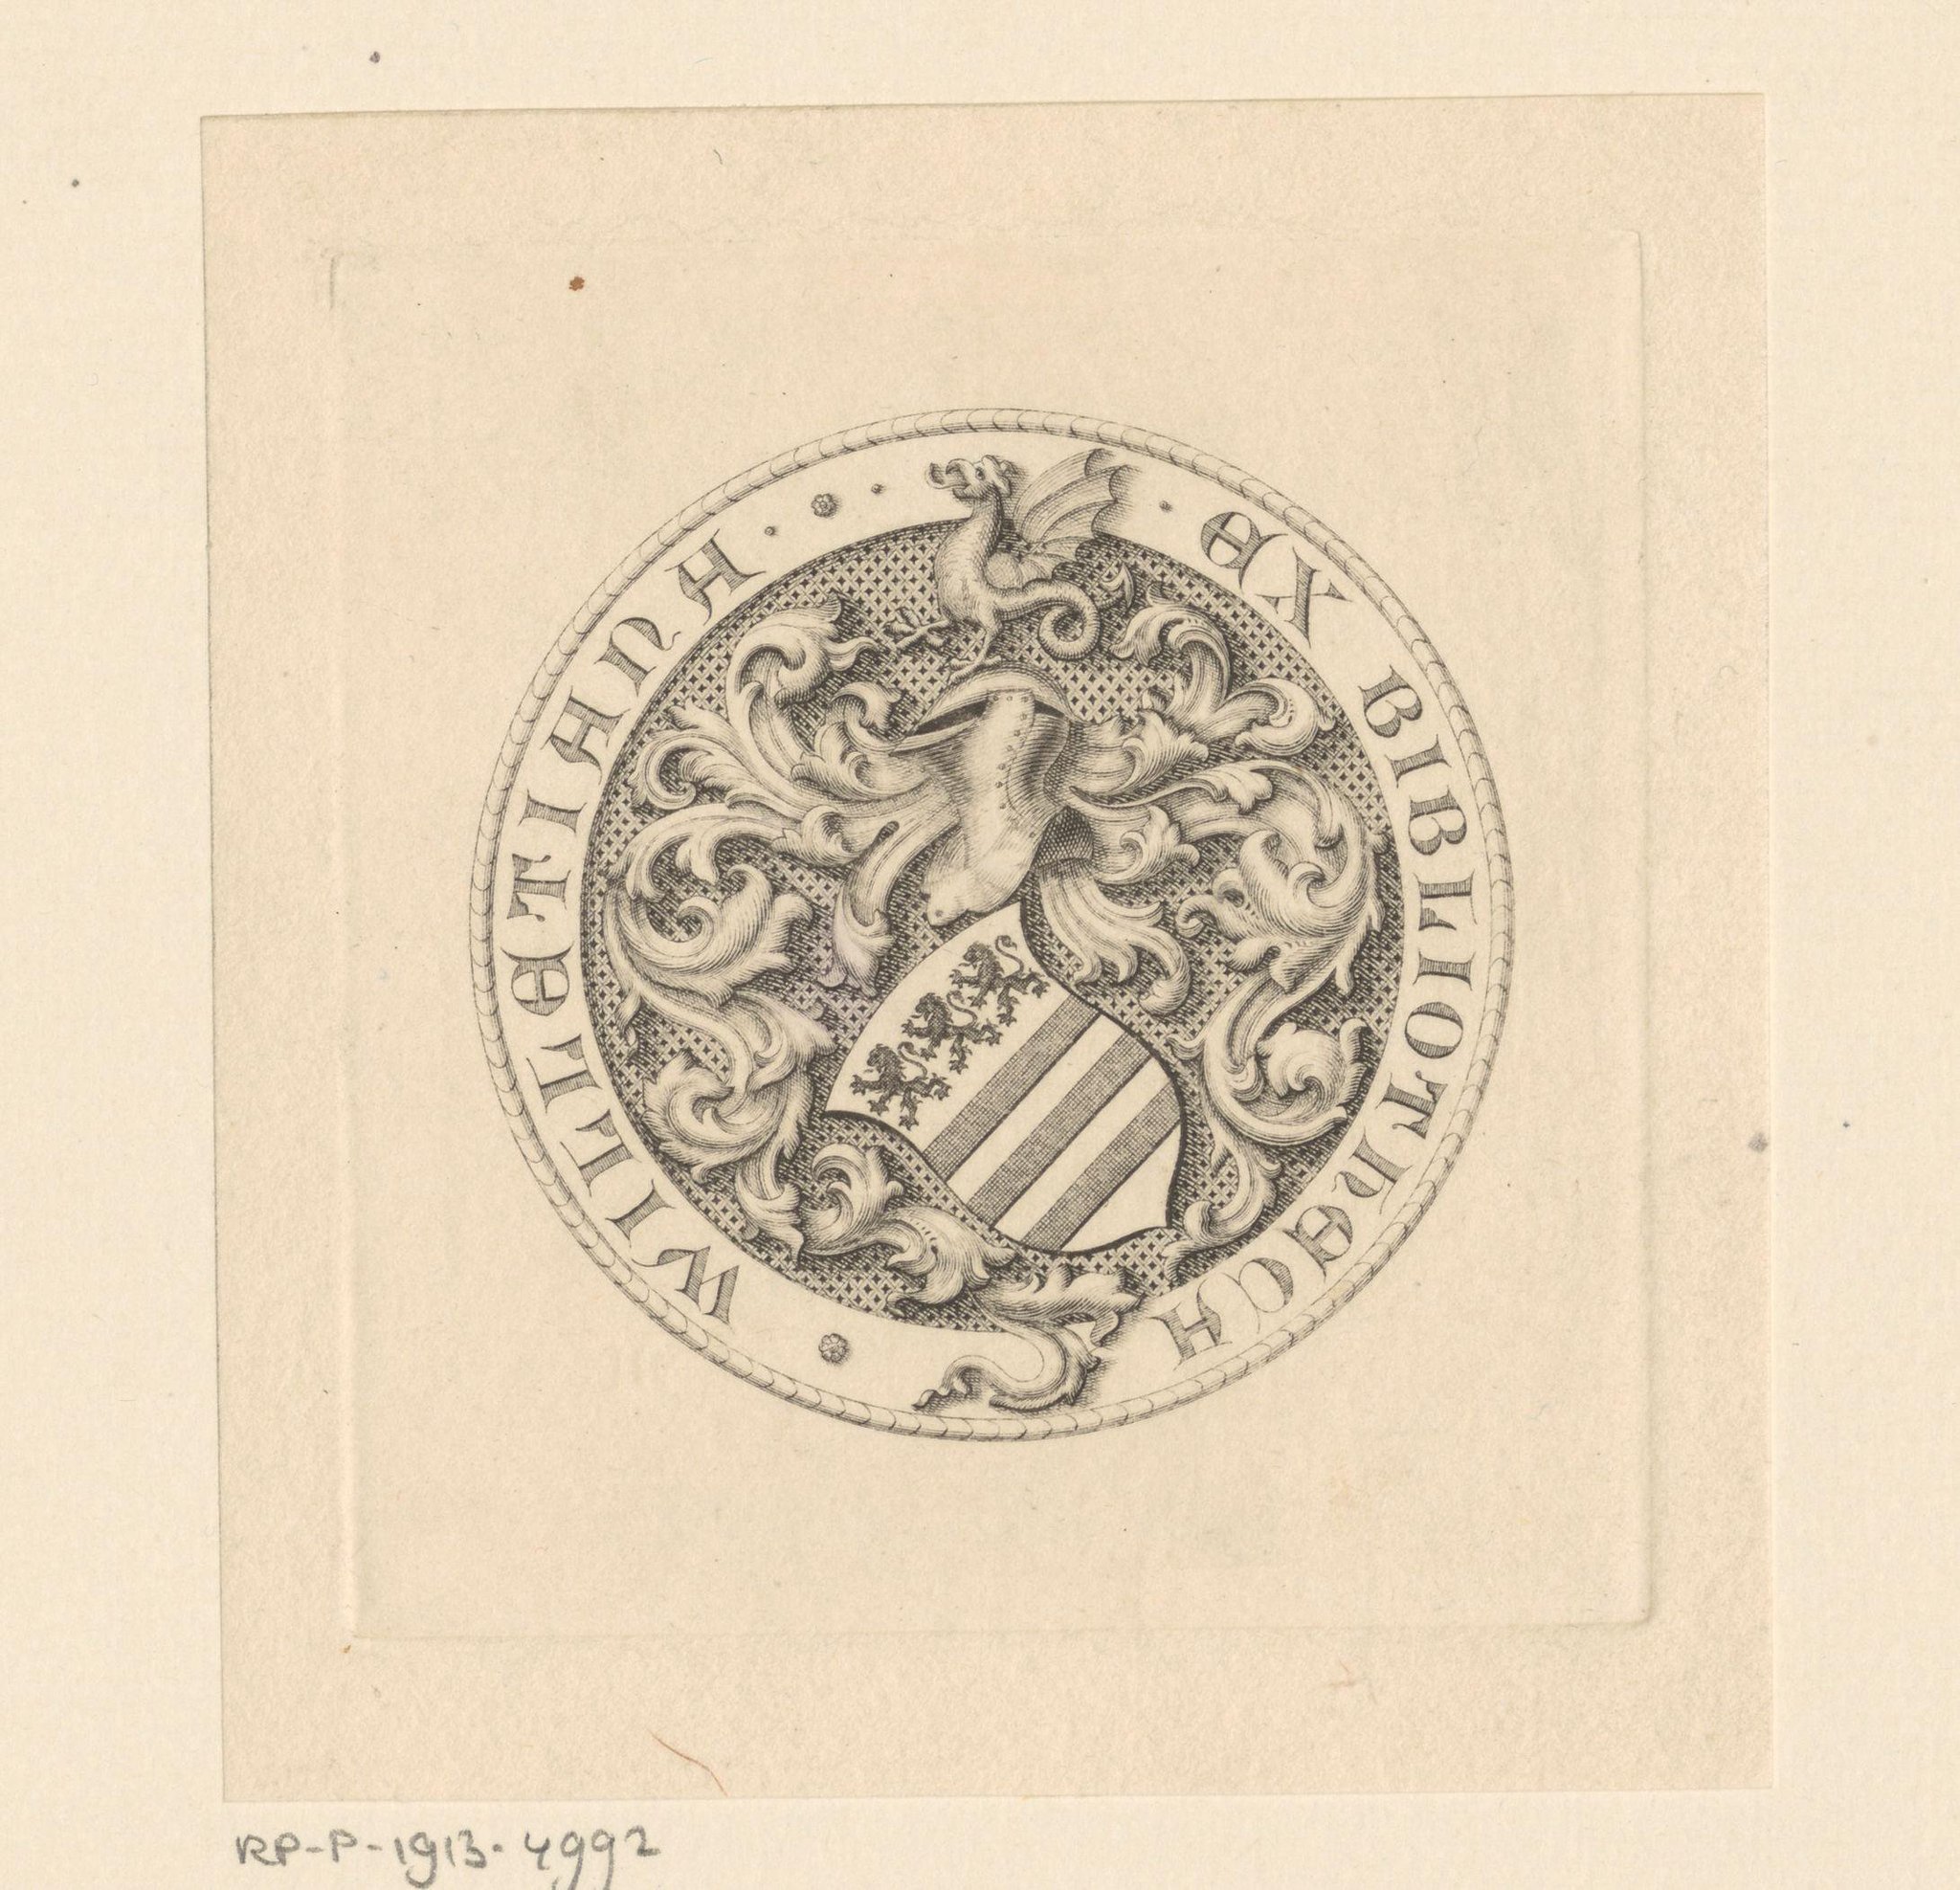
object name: bookplate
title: Ex libris van Abraham Willet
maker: johannes evert van leeuwen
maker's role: painter, print maker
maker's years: 1855-1931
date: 1865-1913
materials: paper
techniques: engraving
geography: netherlands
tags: amsterdam, dragon, armorial bearing, heraldry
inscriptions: collector's mark: Lugt 2233, collector's mark: Lugt 2760